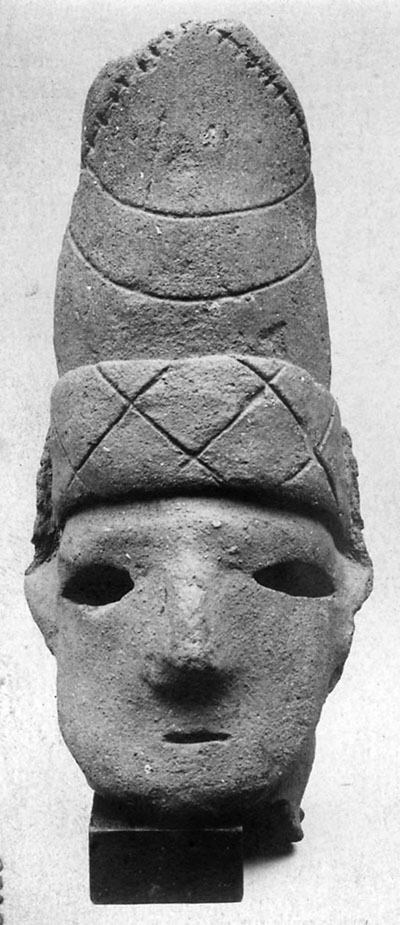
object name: haniwa head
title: Head of a Male Haniwa Figure with Hat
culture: japanese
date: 501-600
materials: earthenware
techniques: incising